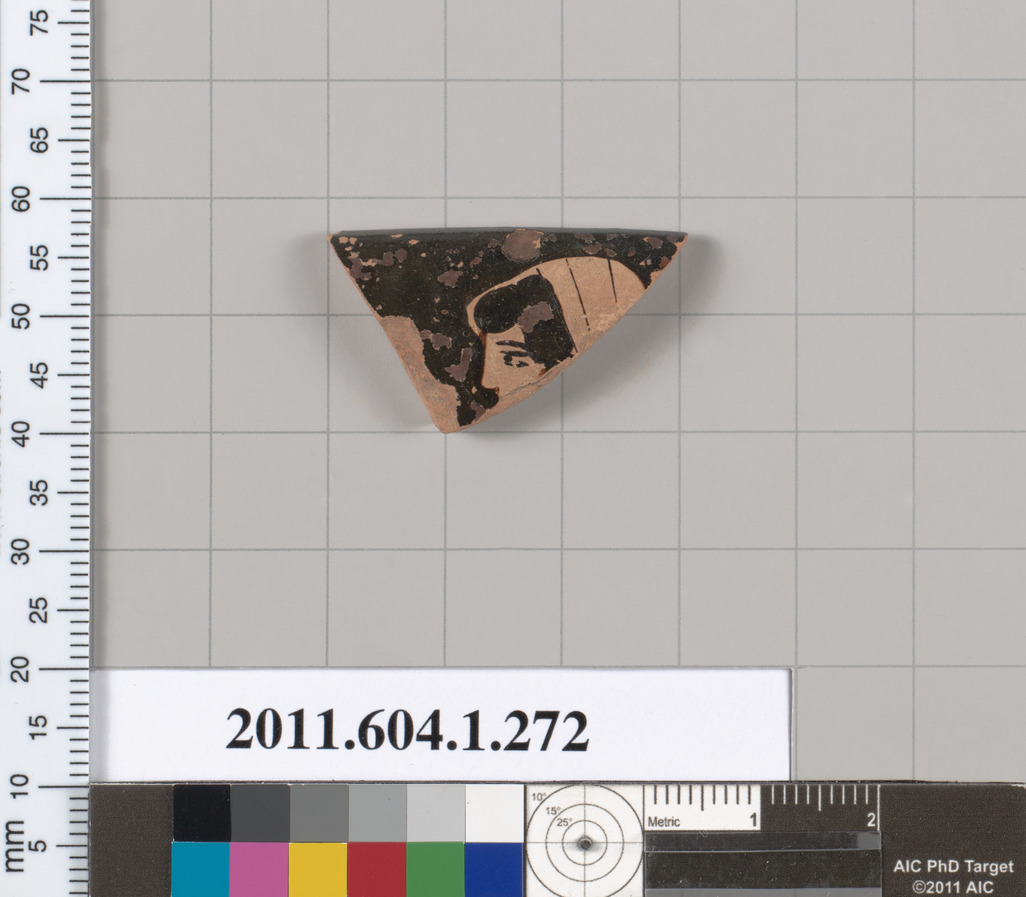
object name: kylix fragment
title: Terracotta rim fragment of a kylix (drinking cup)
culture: greek, attic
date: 475-451 BCE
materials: terracotta